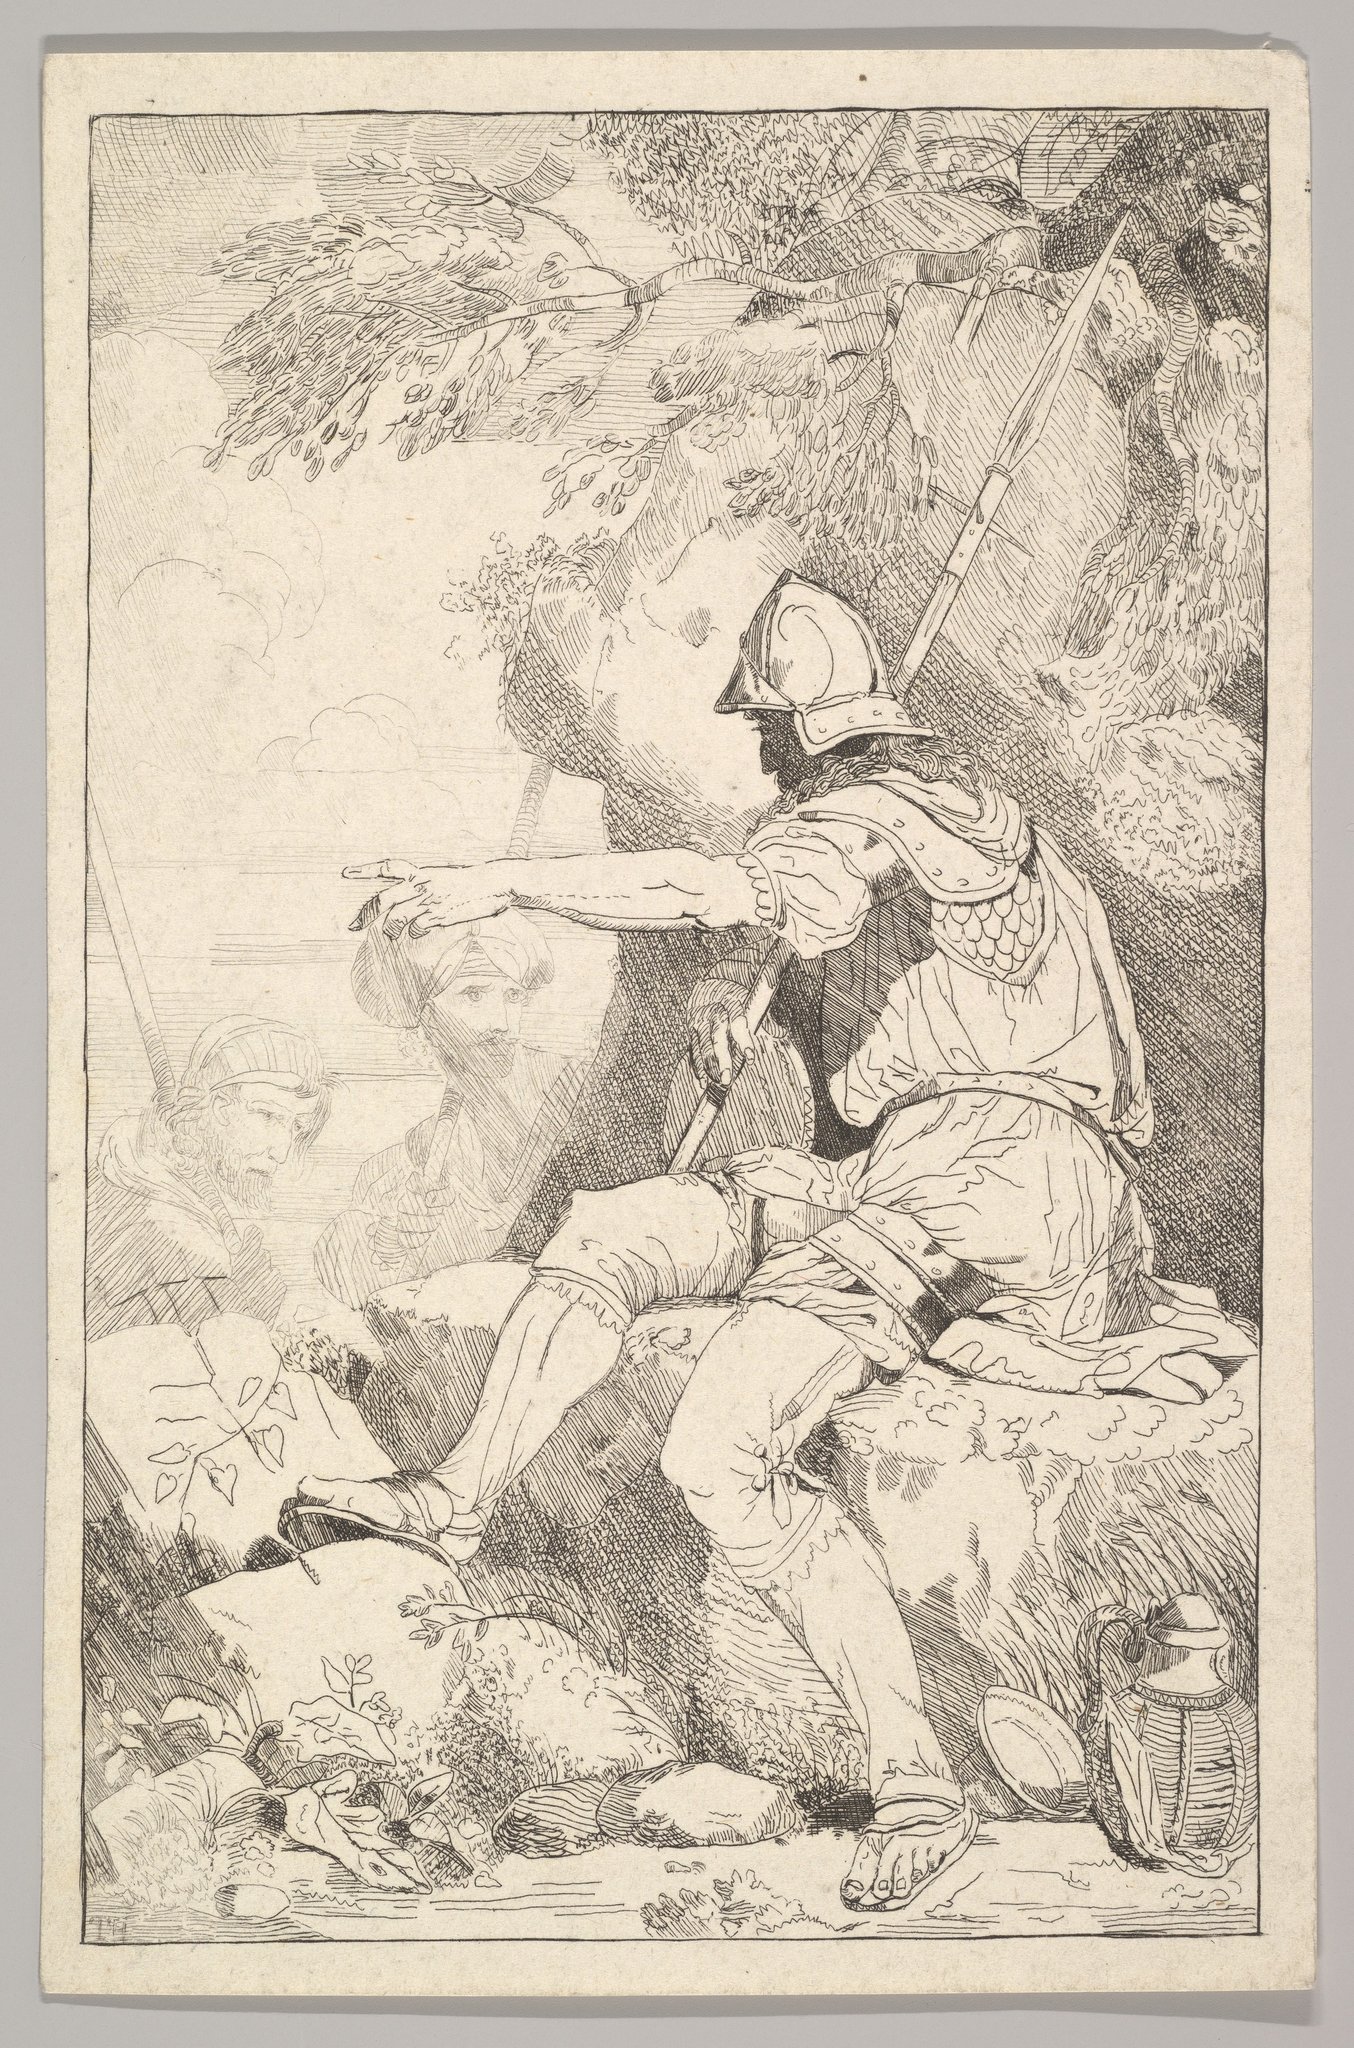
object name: print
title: Banditti Taking His Post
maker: john hamilton mortimer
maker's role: artist and publisher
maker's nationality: british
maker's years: 1740-1779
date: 1767-1800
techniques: etching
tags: spears,men